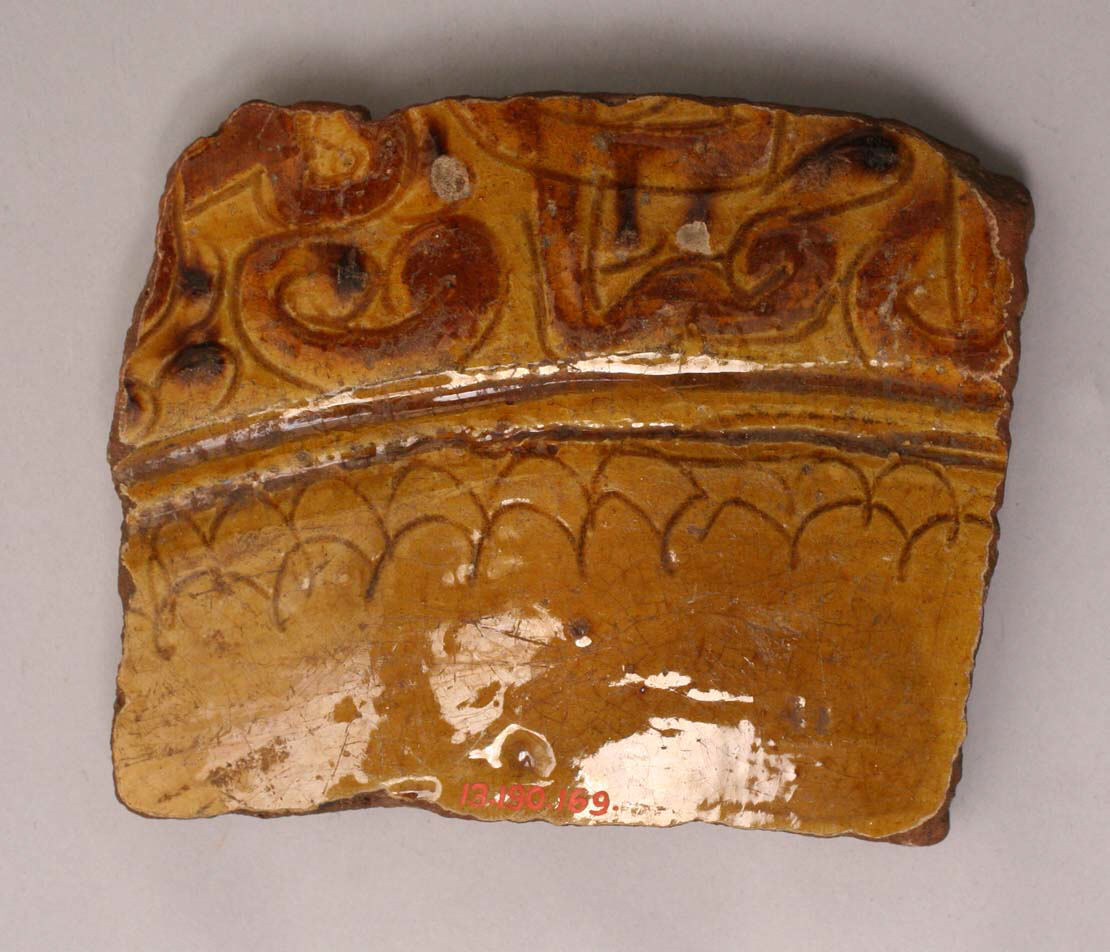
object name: ceramic fragment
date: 1301-1500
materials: earthenware, glaze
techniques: coloring, incising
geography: egypt